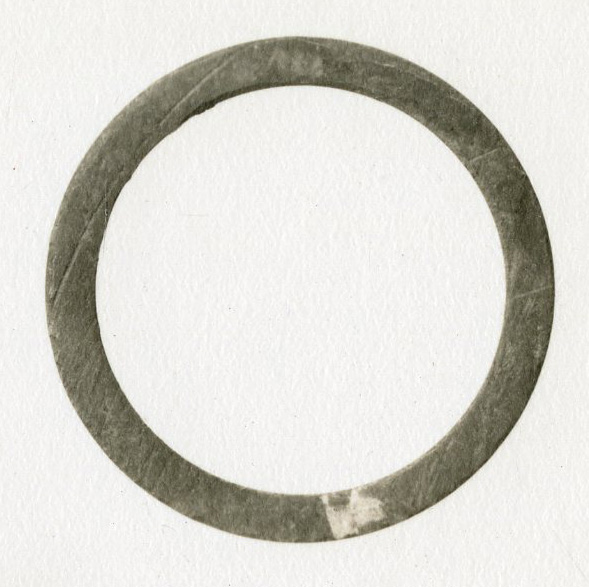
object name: ring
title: Ring?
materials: shell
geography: egypt